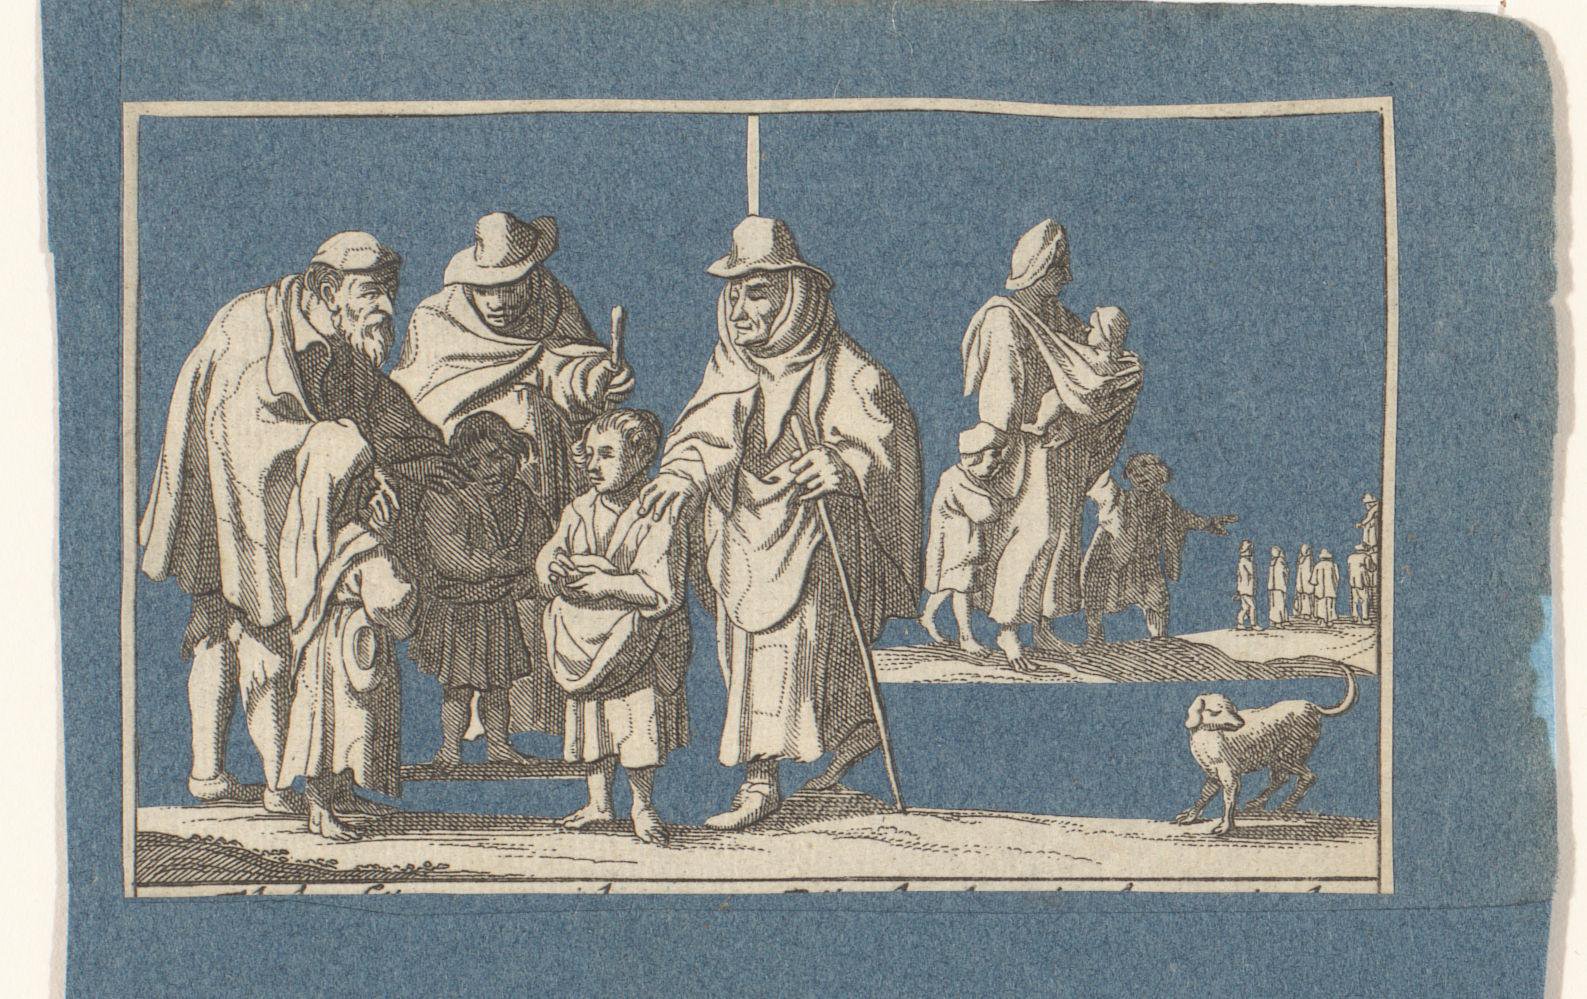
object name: print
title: Fragment van een collage van uitgeknipte prenten, geplakt op blauw papier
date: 1680-1720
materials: paper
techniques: etching, snipping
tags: blind, blindness, old man, old woman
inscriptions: collector's mark: Lugt 2228, collector's mark: Lugt 2760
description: Oude mensen, mogelijk blinden, begeleid door kinderen. Fragment van een collage van uitgeknipte prenten, geplakt op blauw papier.